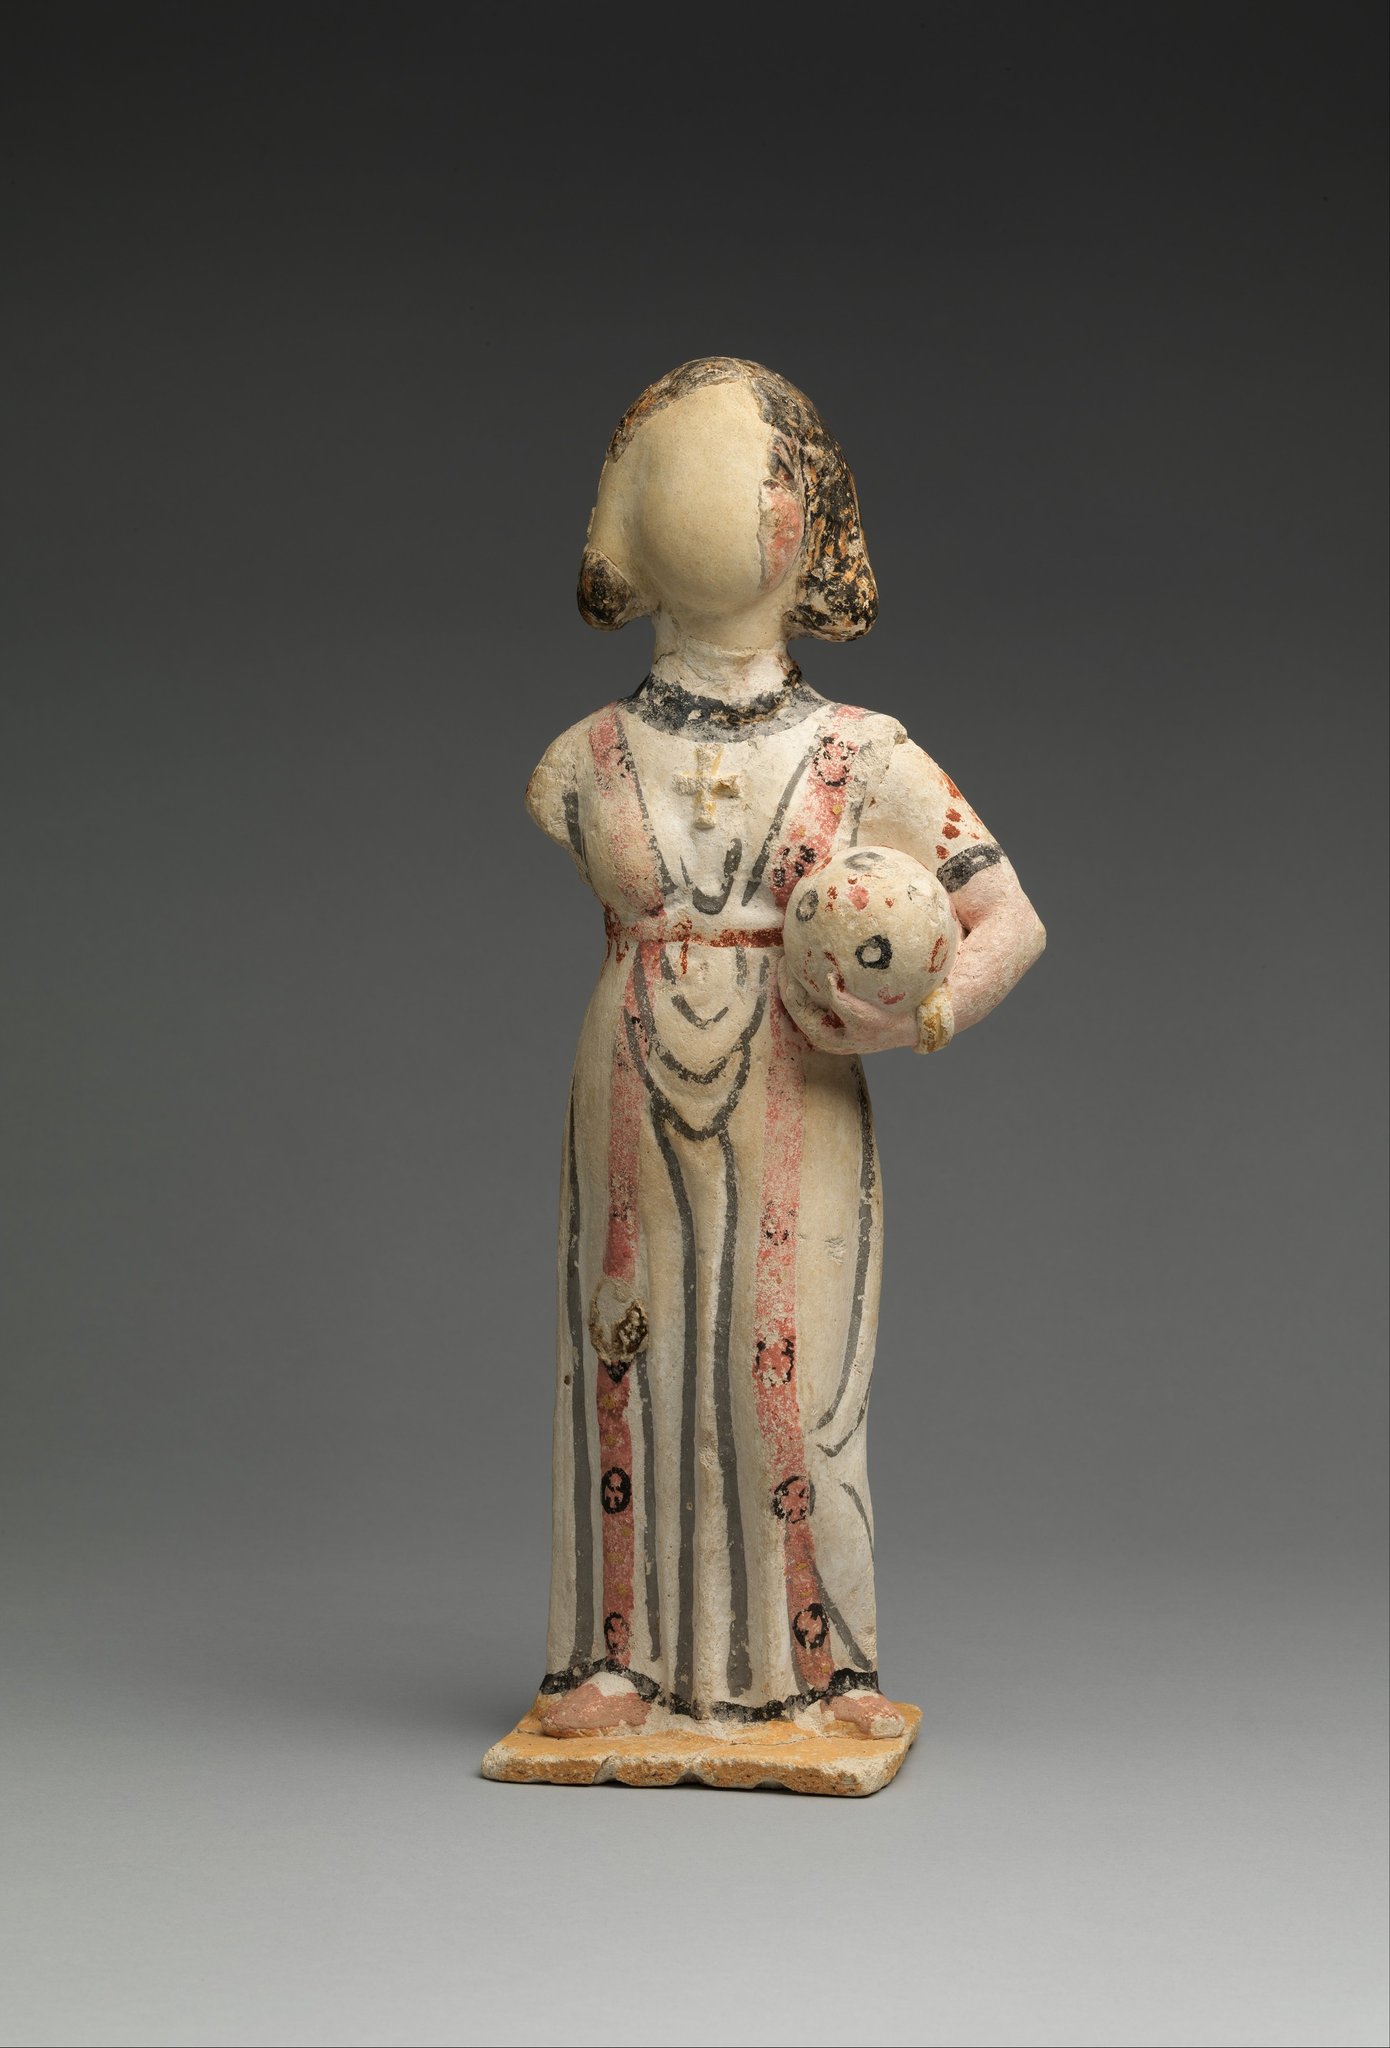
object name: figure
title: Figure of a Woman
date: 401-500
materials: plaster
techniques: painting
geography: egypt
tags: women